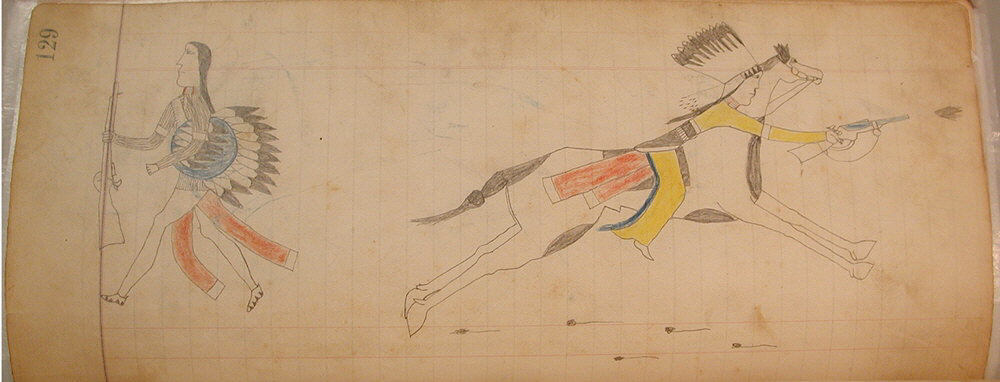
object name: drawing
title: Maffet Ledger: Drawing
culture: cheyenne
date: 1874-1881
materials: crayon, graphite, paper, watercolor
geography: united states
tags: firearms,men,horses